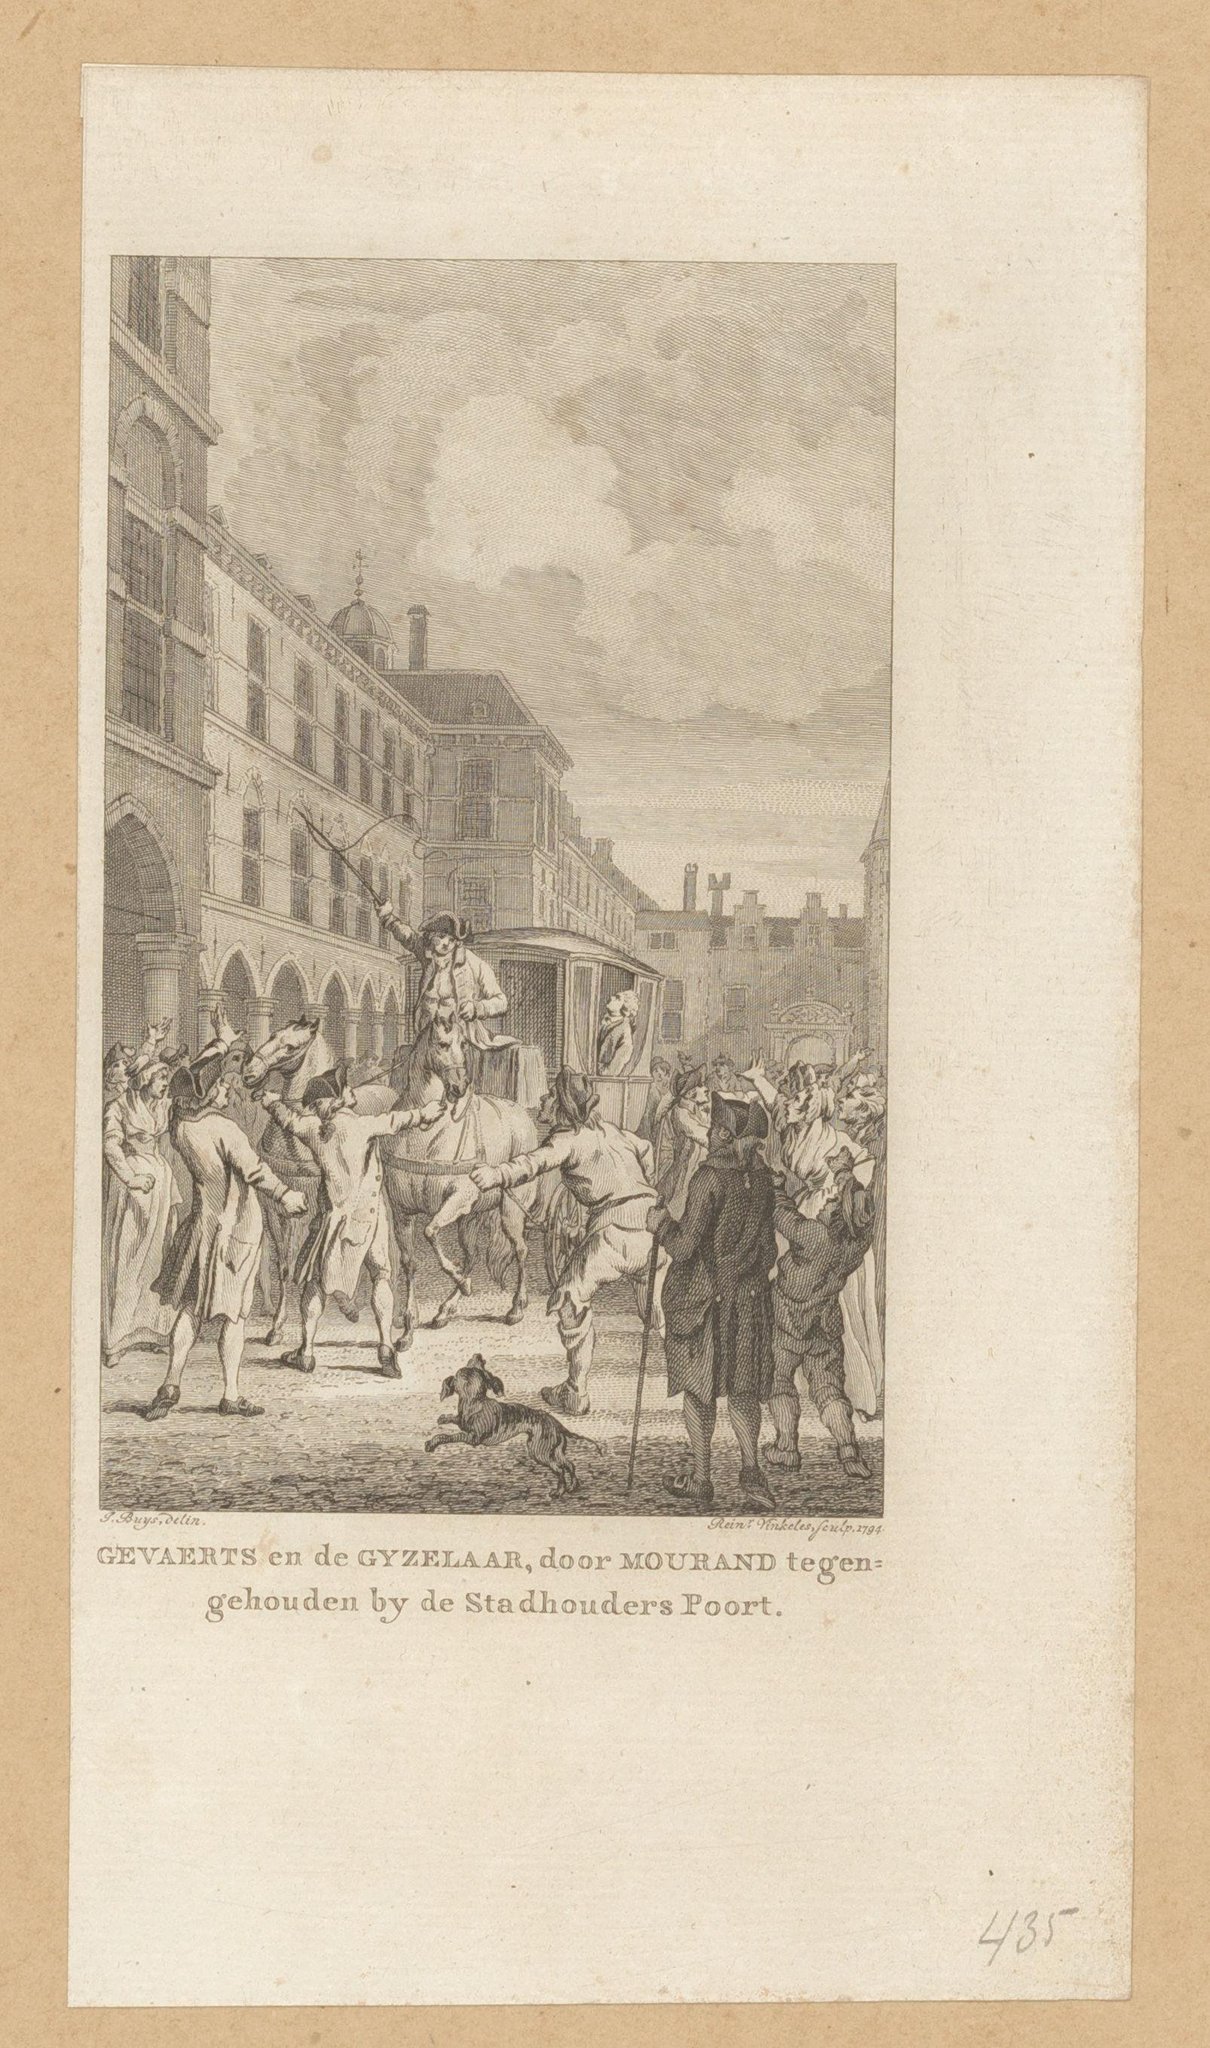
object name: book illustration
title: Rijtuig met de gedeputeerden van Dordrecht tegengehouden bij de Stadhouderspoort, 1786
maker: reinier vinkeles (i)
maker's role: draughtsman, print maker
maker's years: 1741-1816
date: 1794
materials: paper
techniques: engraving, etching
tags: four-wheeled vehicle drawn by two animals, revolutionary action (violent)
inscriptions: stamp, collector's mark: Lugt 1641, stamp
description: Ongeregeldheden als de gedeputeerden van Dordrecht, de heren Gevaerts en De Gijzelaar, met hun rijtuig door de Stadhouderspoort het Binnenhof op willen rijden en hun paarden bij de toom worden gegrepen door de Haagse pruikenmaker F. Mourand, 17 maart 1786. Onderwerpsrubrieken binnen de Atlas Zeden en Gewoonten: Vervoermiddelen te land en te water, Vervoermiddelen te land, Rijtuigen en Statiekarossen.